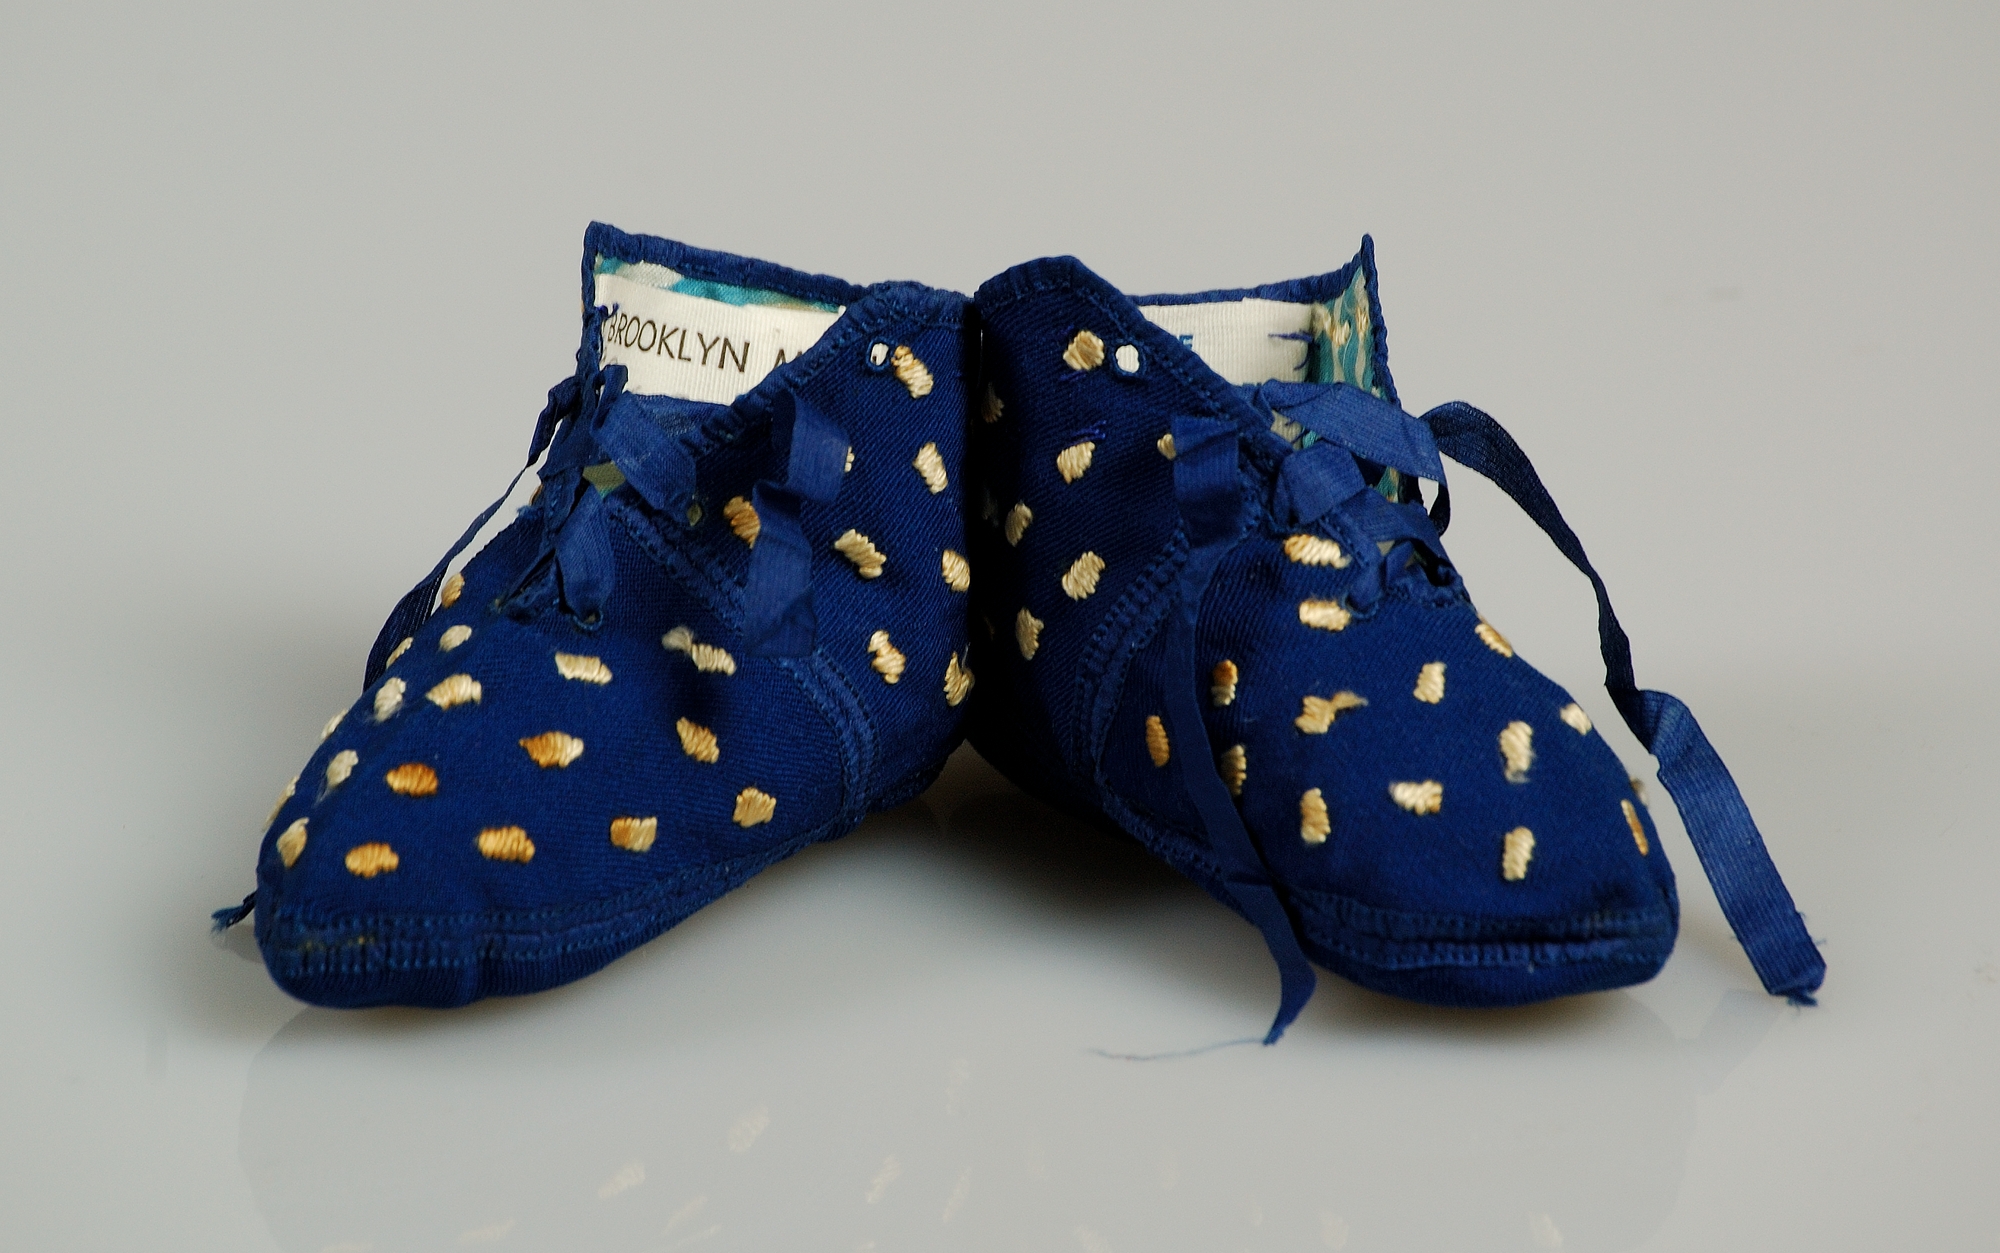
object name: bootee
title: Bootees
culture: american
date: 1860-1880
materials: silk, wool